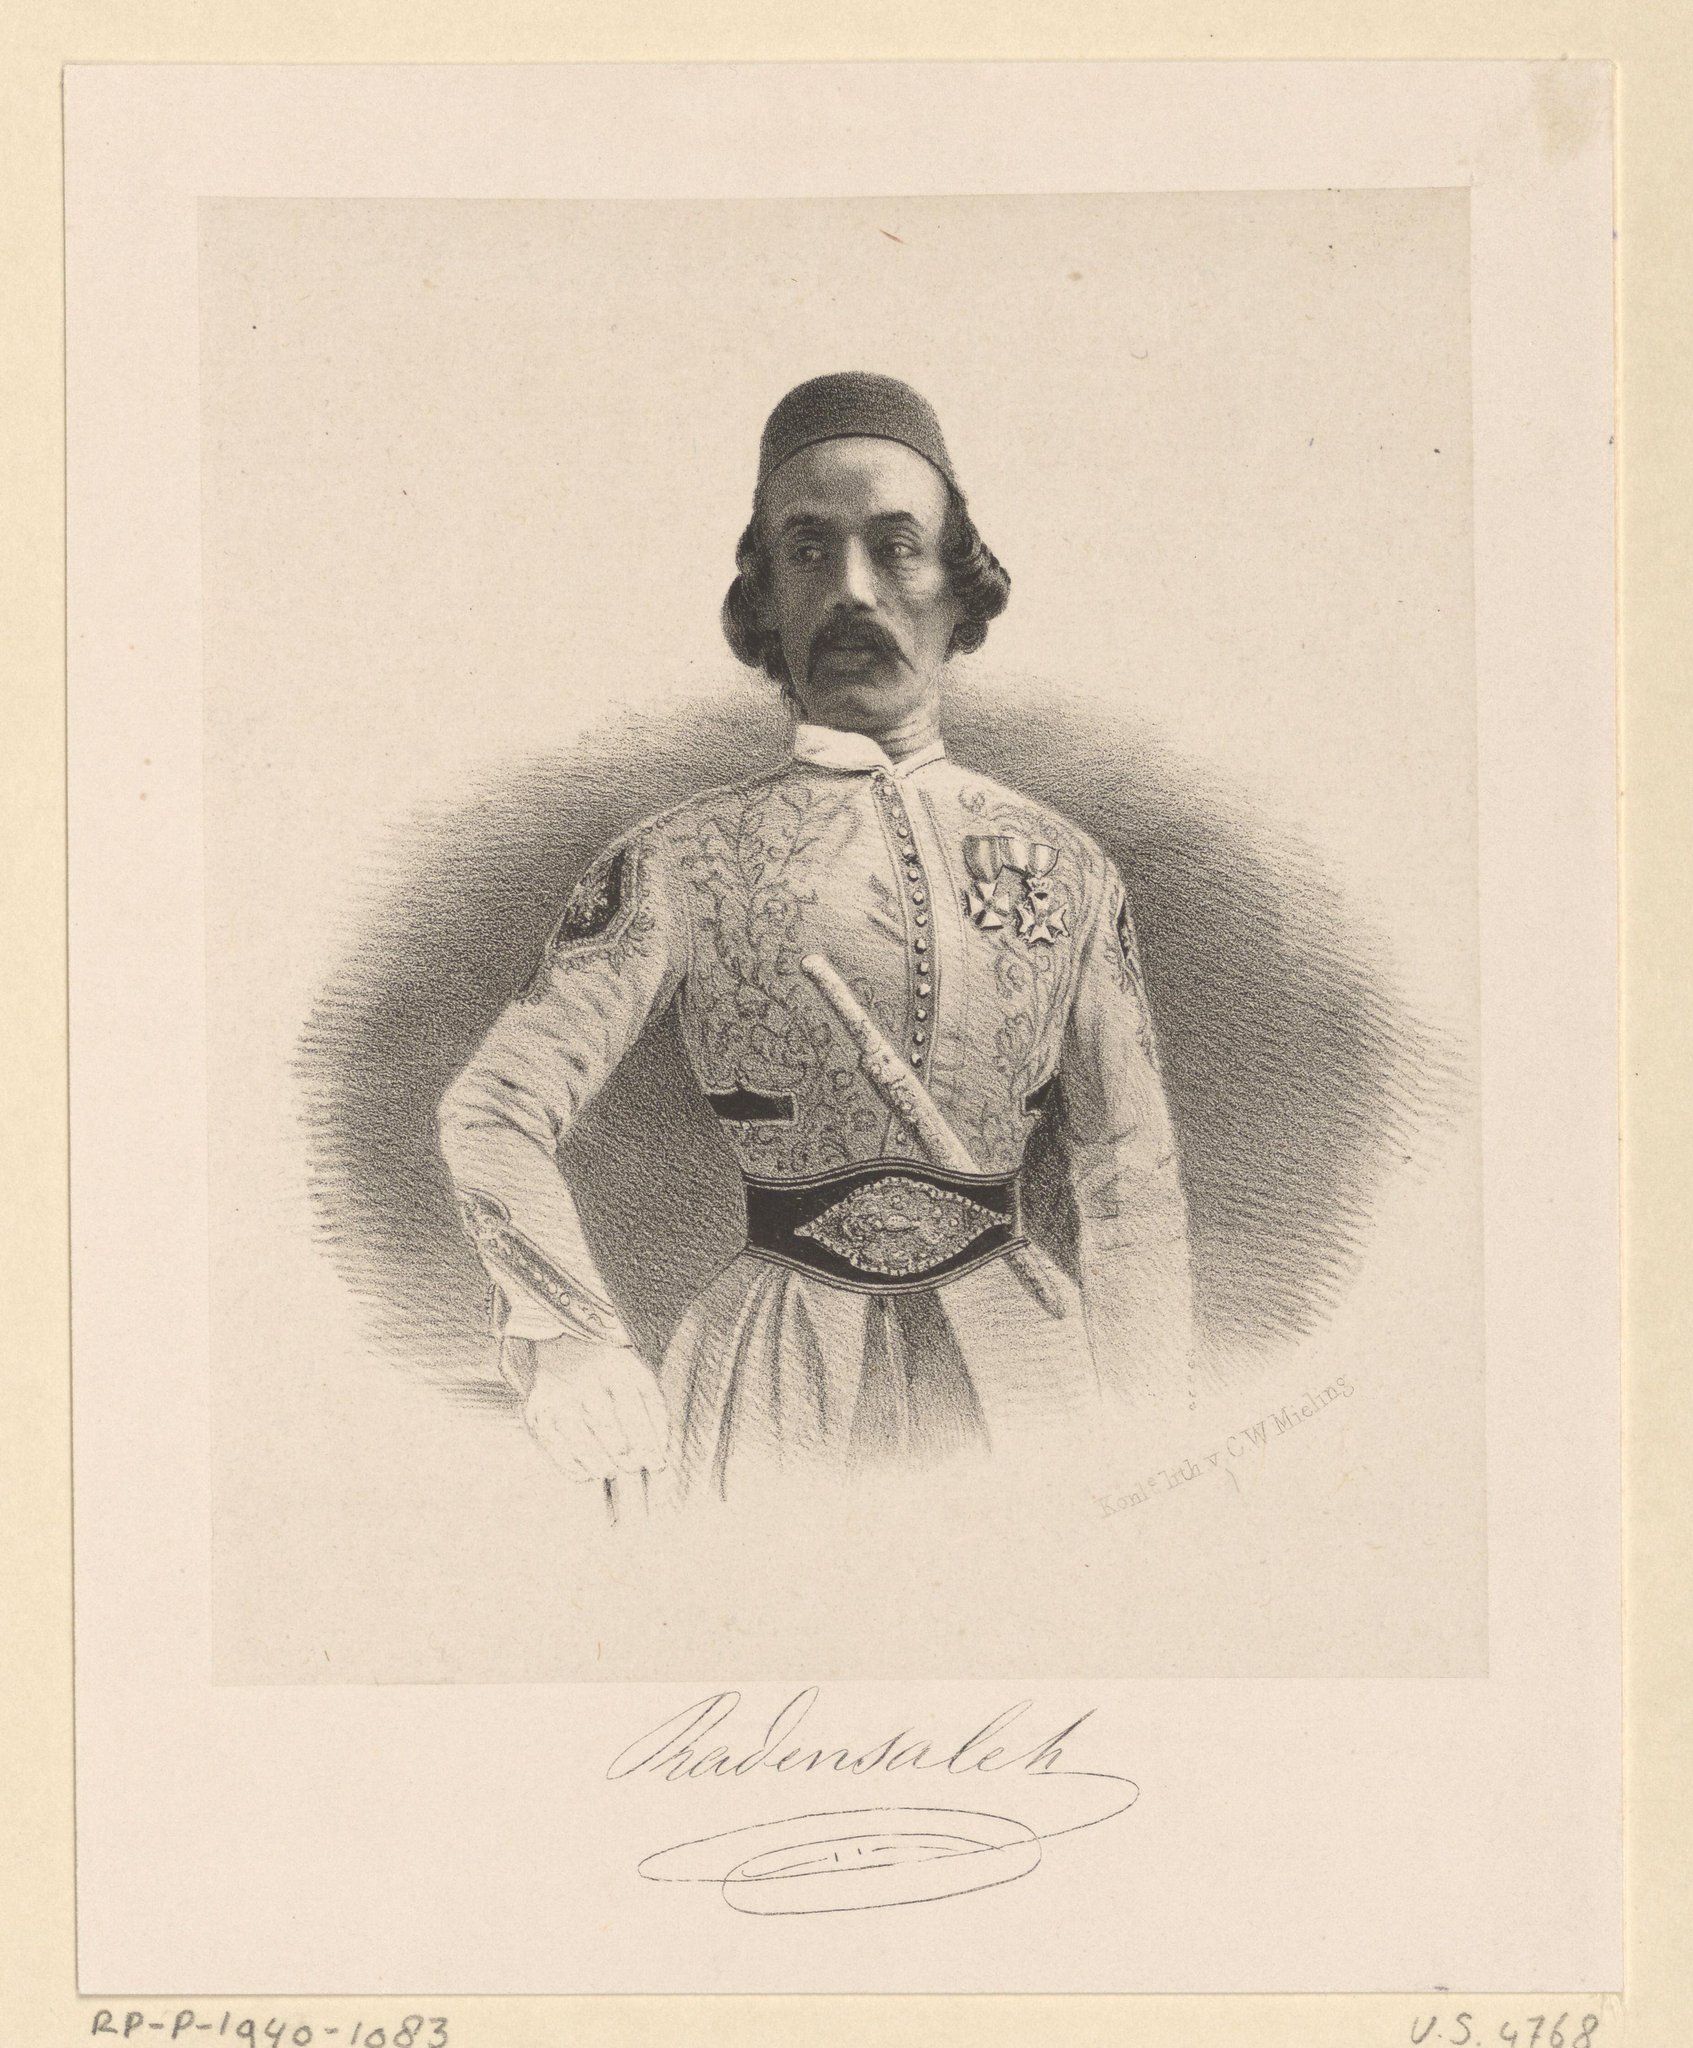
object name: print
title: Portret van Raden Sarief Bastaman Saleh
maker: Anonymous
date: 1847-1865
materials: paper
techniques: lithograph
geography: the hague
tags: painter, draughtsman, raden sarief bastaman saleh, historical persons, portrait, self-portrait of painter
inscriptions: collector's mark: Lugt 2228, collector's mark: Lugt 2760